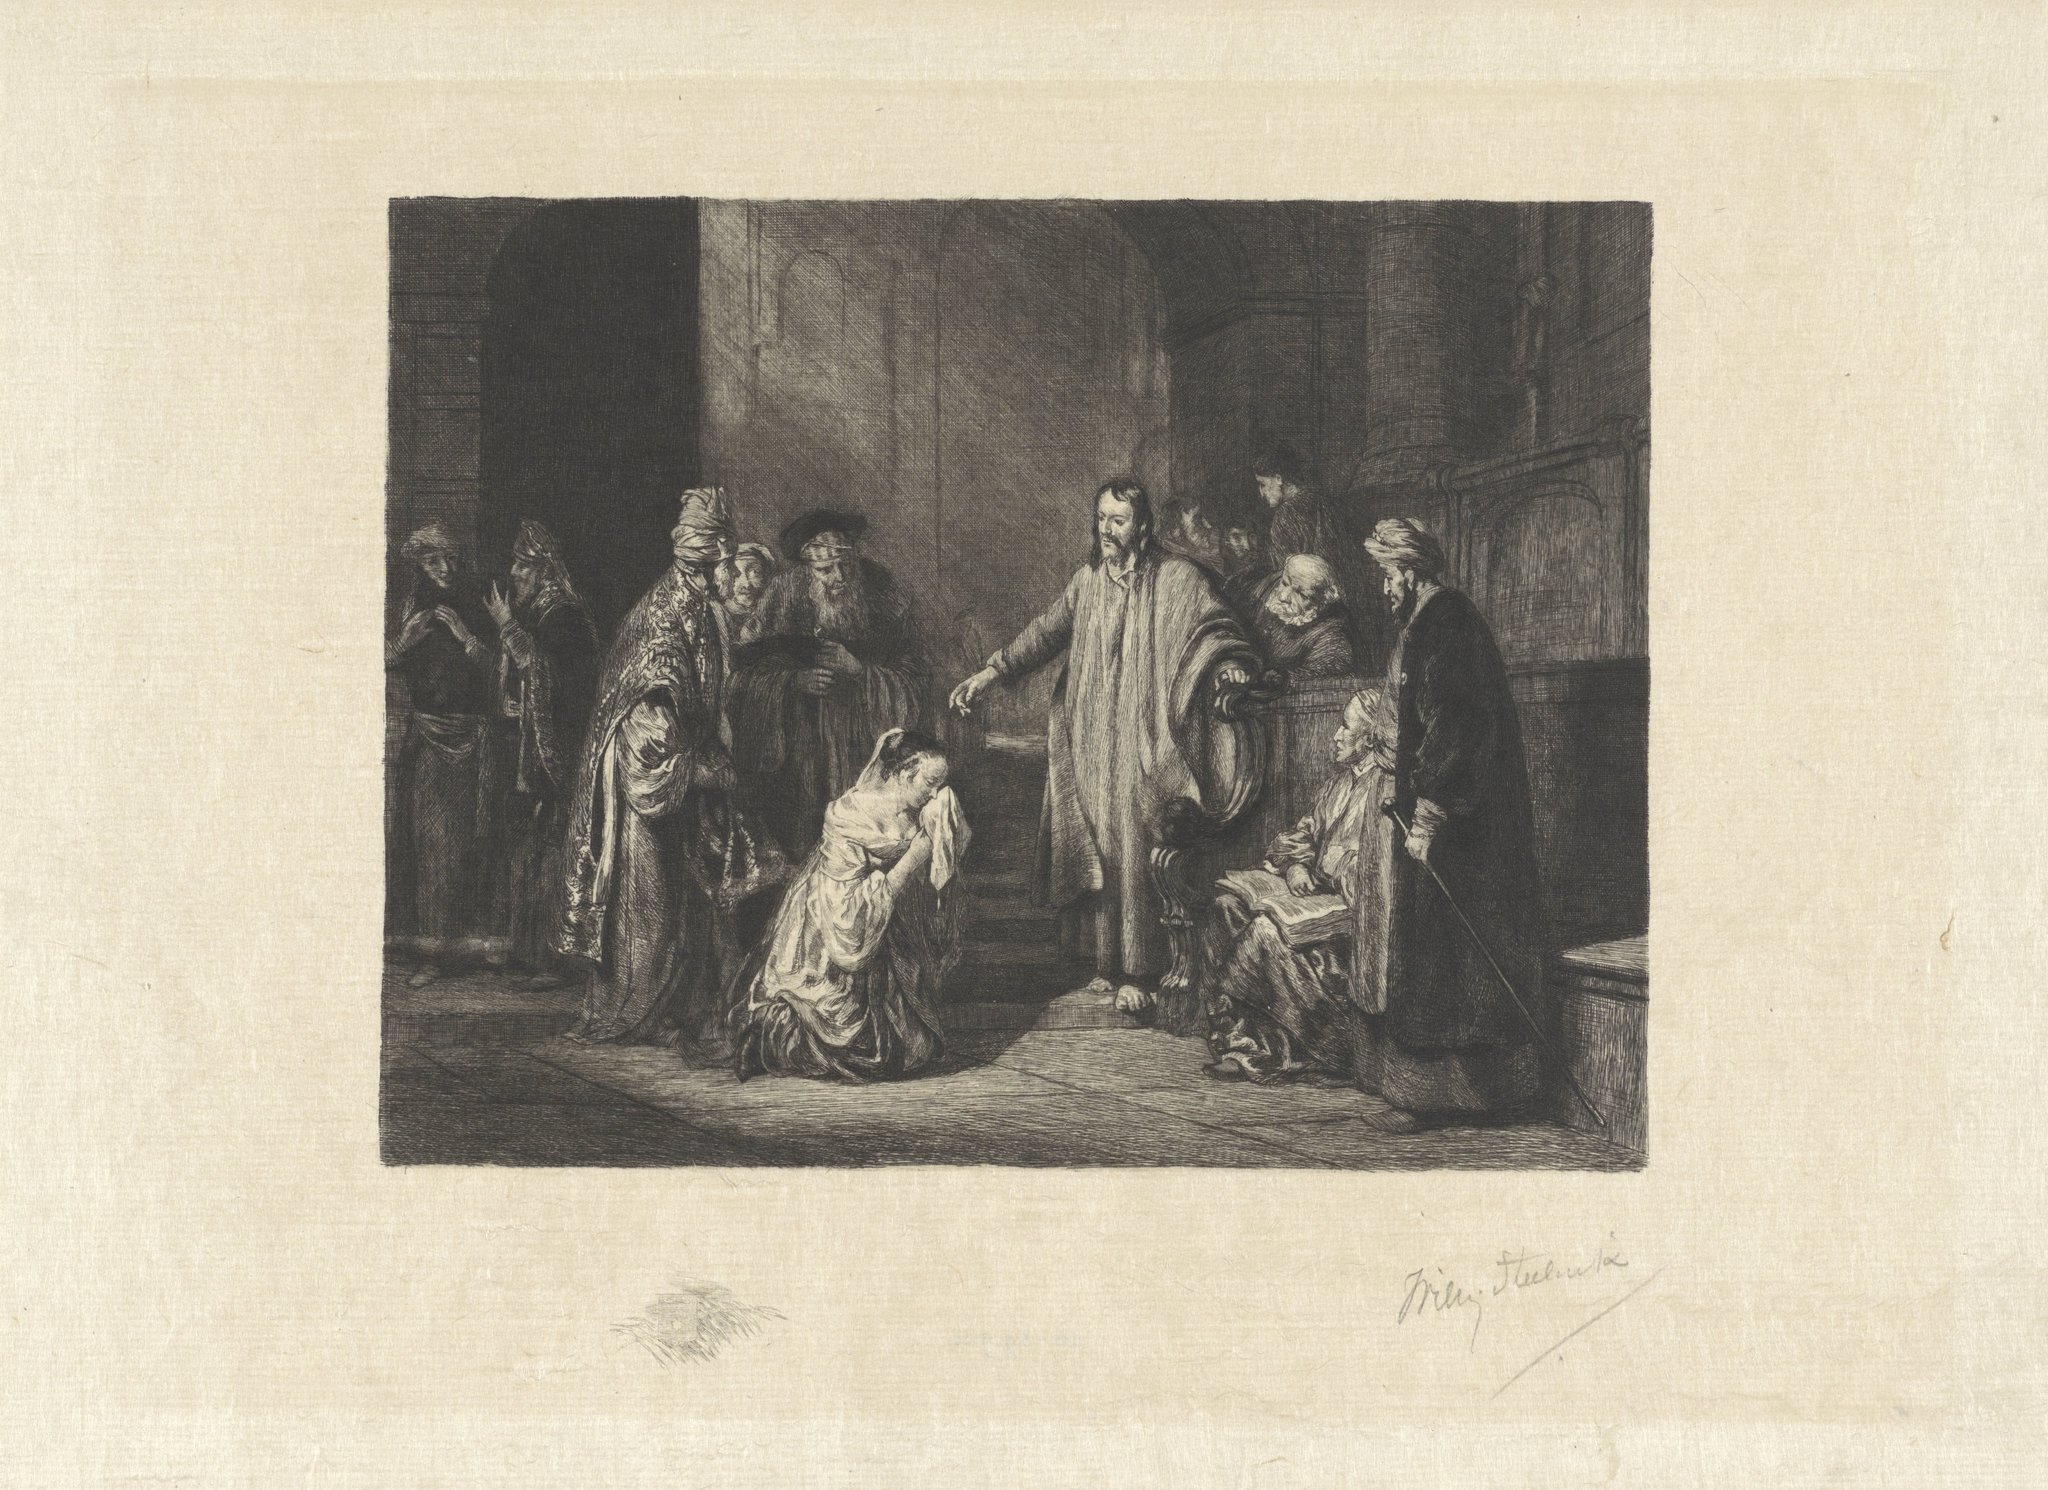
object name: print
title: Christus en de overspelige vrouw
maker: willem steelink (ii)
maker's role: draughtsman, print maker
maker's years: 1856-1928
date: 1888-1891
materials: paper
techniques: etching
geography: netherlands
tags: pharisees bring a woman accused of adultery before christ (john 8:2-11)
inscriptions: collector's mark: Lugt 2228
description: Prent mogelijk gebruikt in: Oude kunst in Nederland : etsen van Wilm. Steelink, naar schilderijen uit de kabinetten van A. Bredius, A.J. Enschedé, J.P. Six, P.H. Siz, H.A. Steengracht van Duivenvoorde, Victor de Stuers en andere verzamelingen. Amsterdam: Van Holkema & Warendorf, 1888-1891.